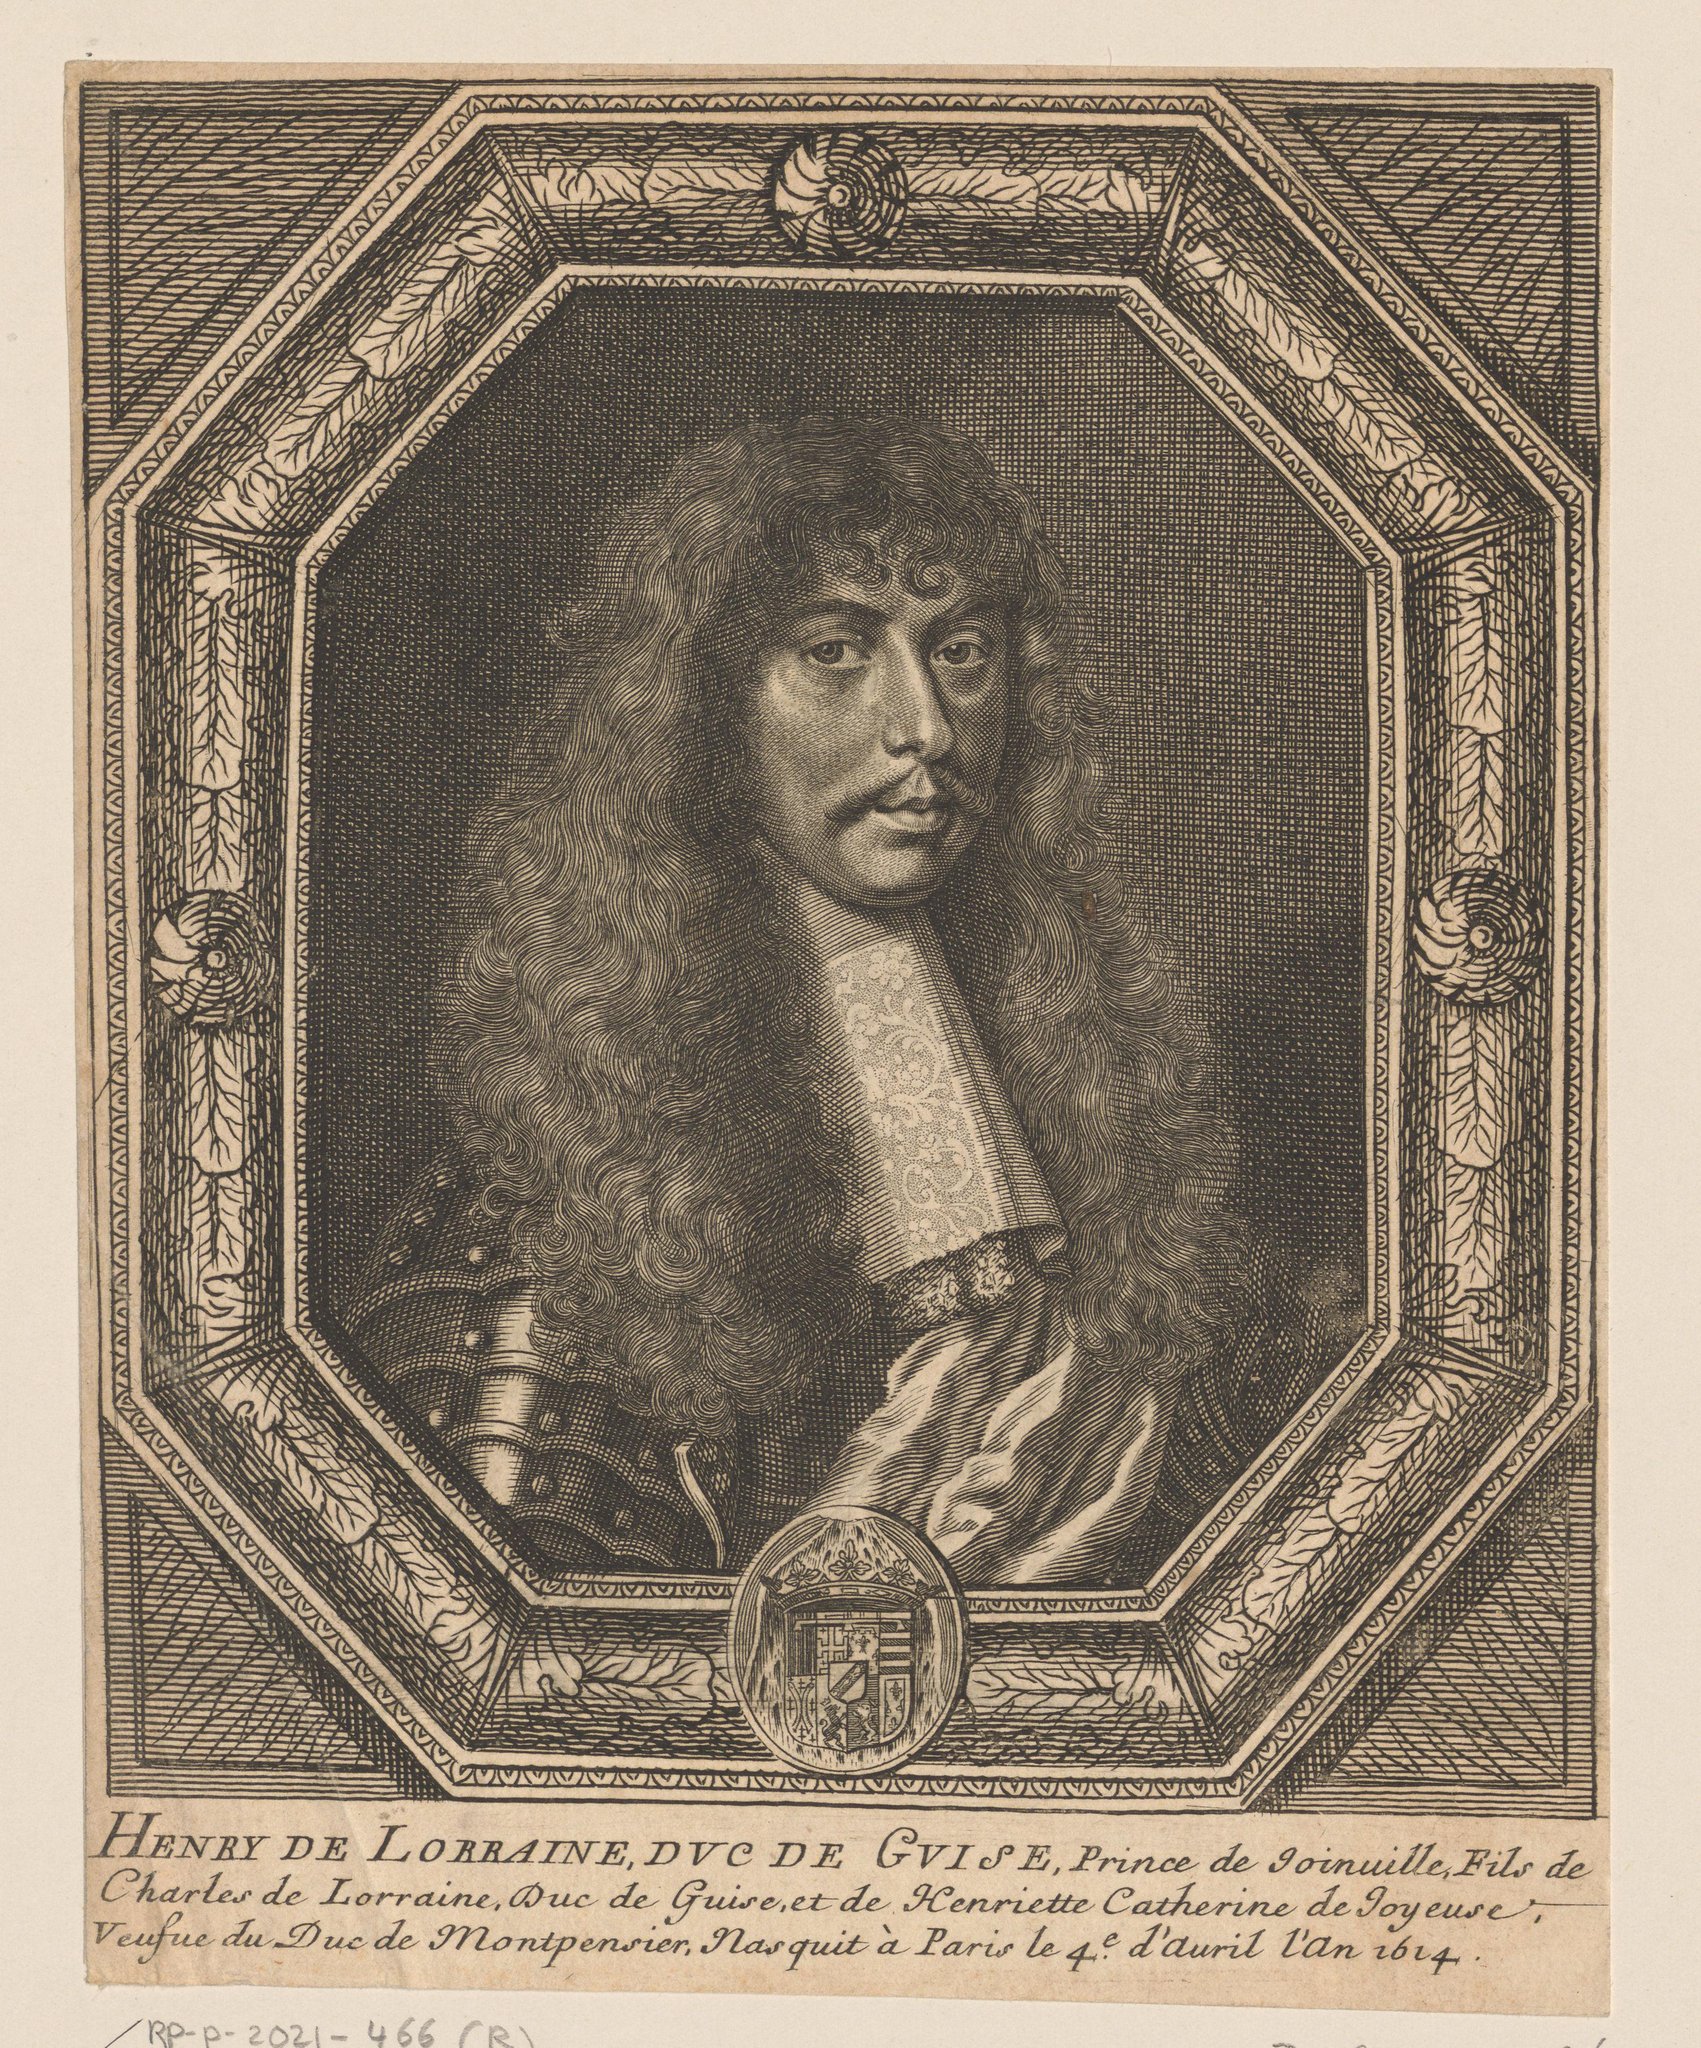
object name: print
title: Portret van Hendrik II de Lorraine, hertog van Guise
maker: Anonymous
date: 1614-1700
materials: paper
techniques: engraving, etching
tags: paris, historical persons